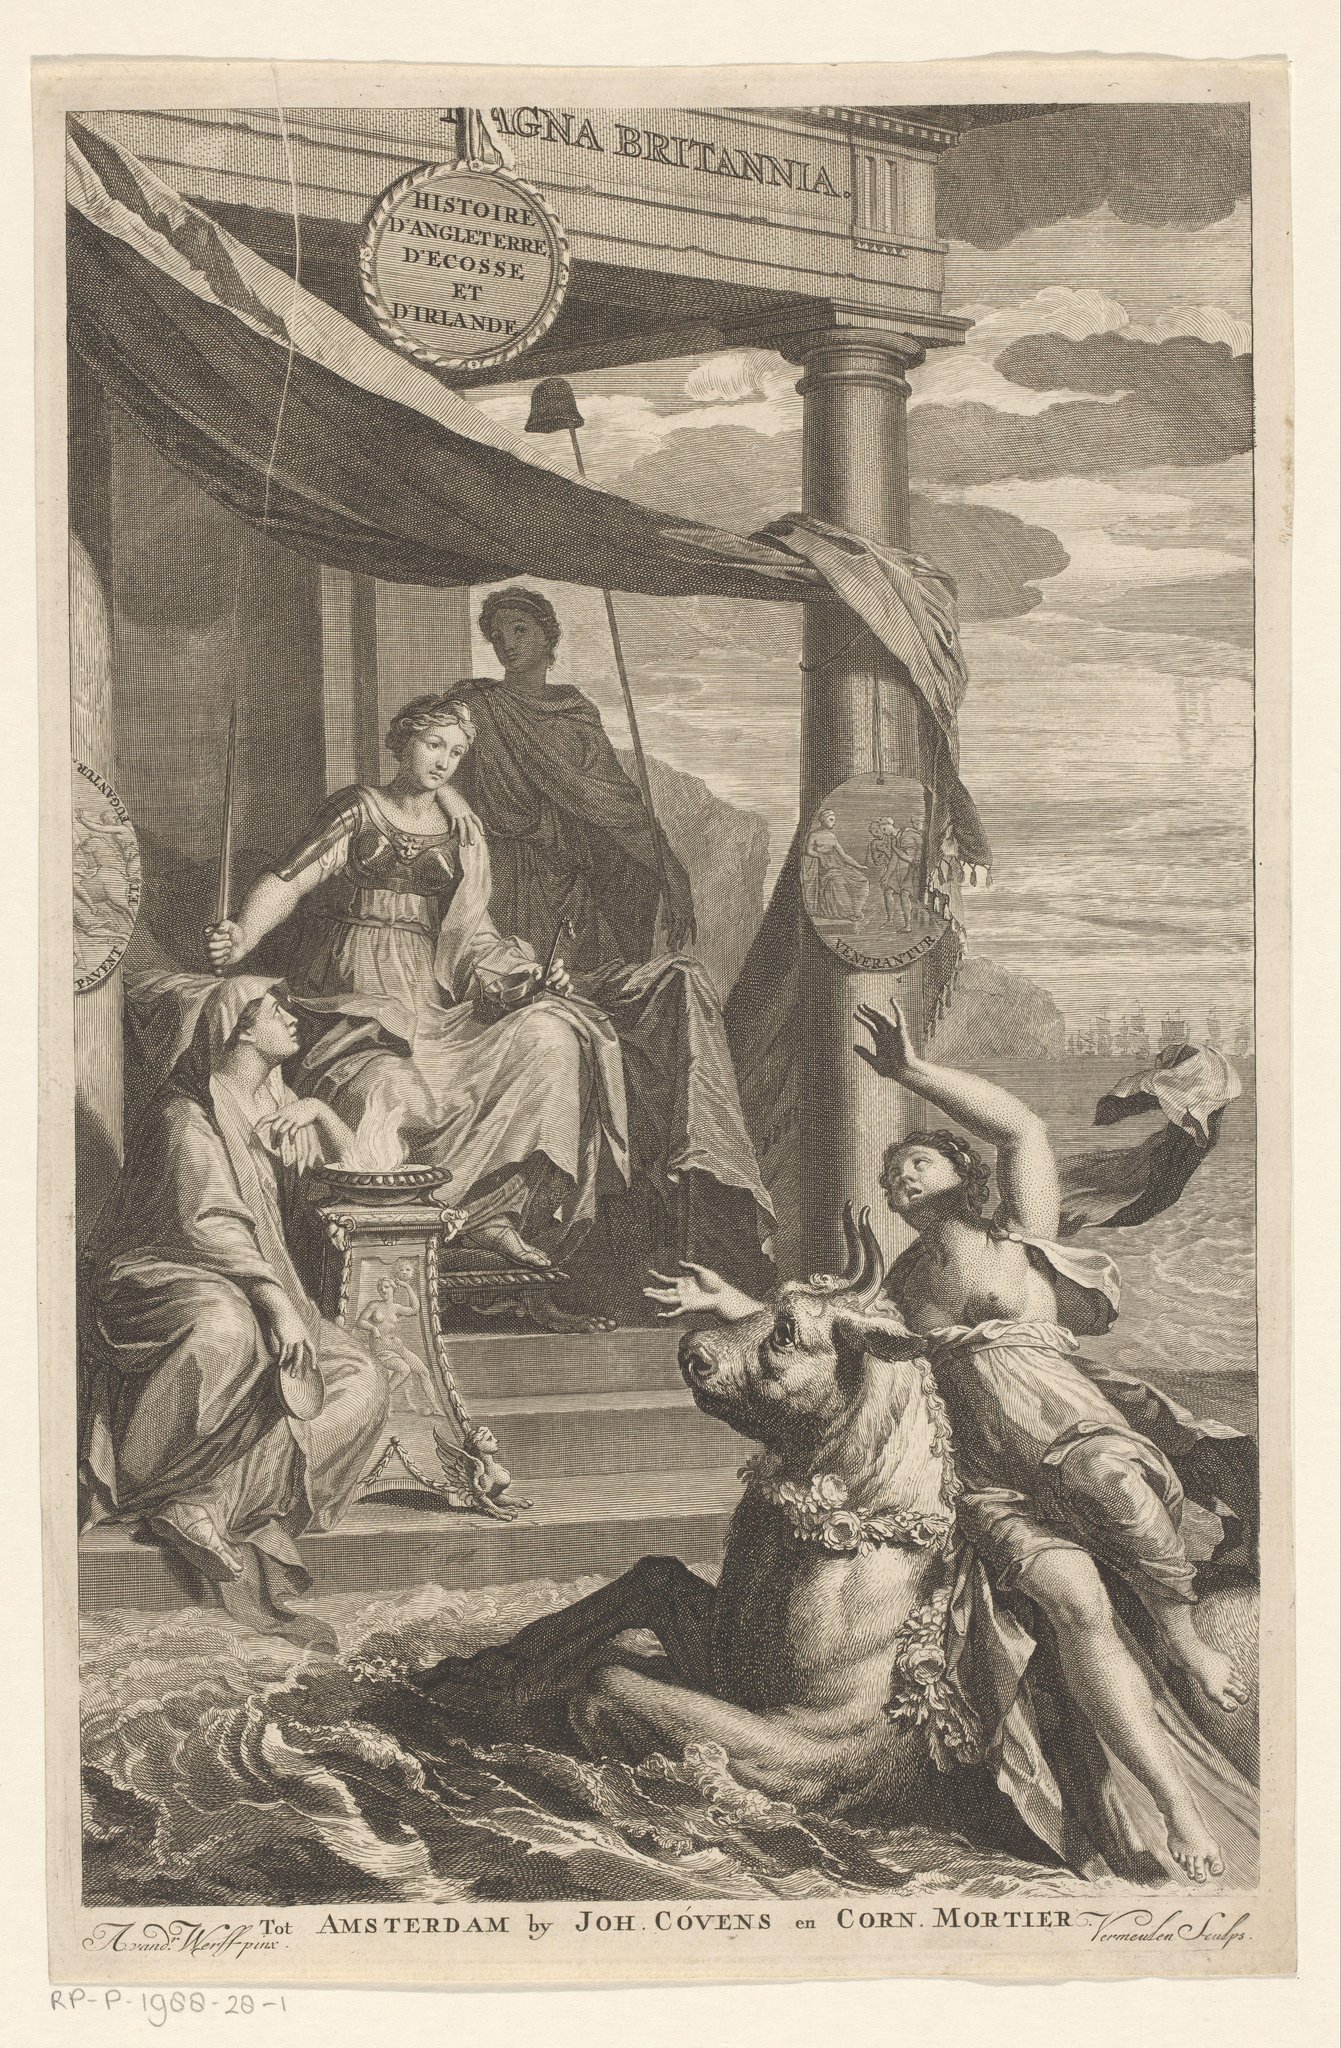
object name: print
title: Titelpagina voor: Isaac de Larrey, Histoire d'Angleterre d'Ecosse et d'Irlande, s.a.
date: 1697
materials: paper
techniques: engraving, etching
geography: amsterdam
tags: jupiter, usually in the shape of a white bull, abducts europa and carries her across the water, personifications of countries, nations, states, districts, etc., justitia (justice) as roman personification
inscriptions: collector's mark: Lugt 2228, collector's mark: Lugt 2760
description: De ontvoering van Europa door Jupiter in de gedaante van een stier. Britannia, gepersonifieerd door Themis als personificatie van Gerechtigheid, zit met weegschaal en zwaard getroond tussen twee zuilen onder een draperie en kijkt toe. Links zit een vrouw naast een brandend altaar. Rechts staat een vrouw met lans met vrijheidshoed. In de achtergrond een vloot.